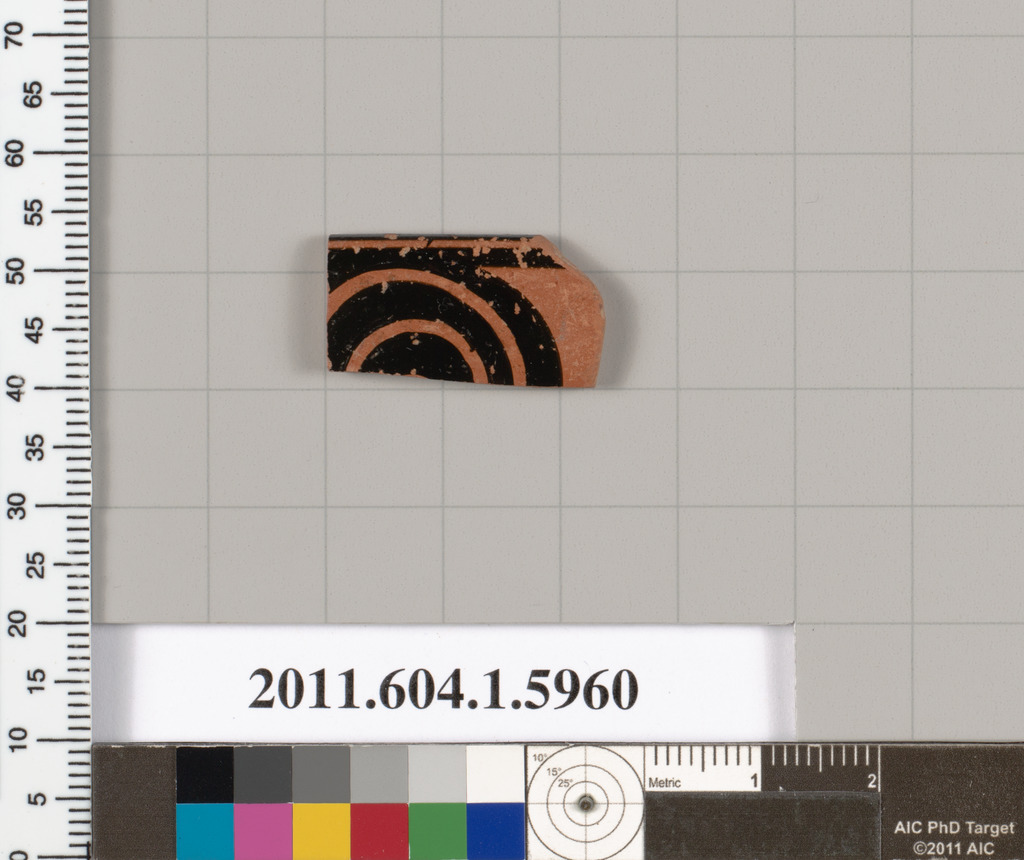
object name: kylix fragment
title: Terracotta rim fragment of a kylix (drinking cup)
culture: greek, attic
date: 433-567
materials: terracotta